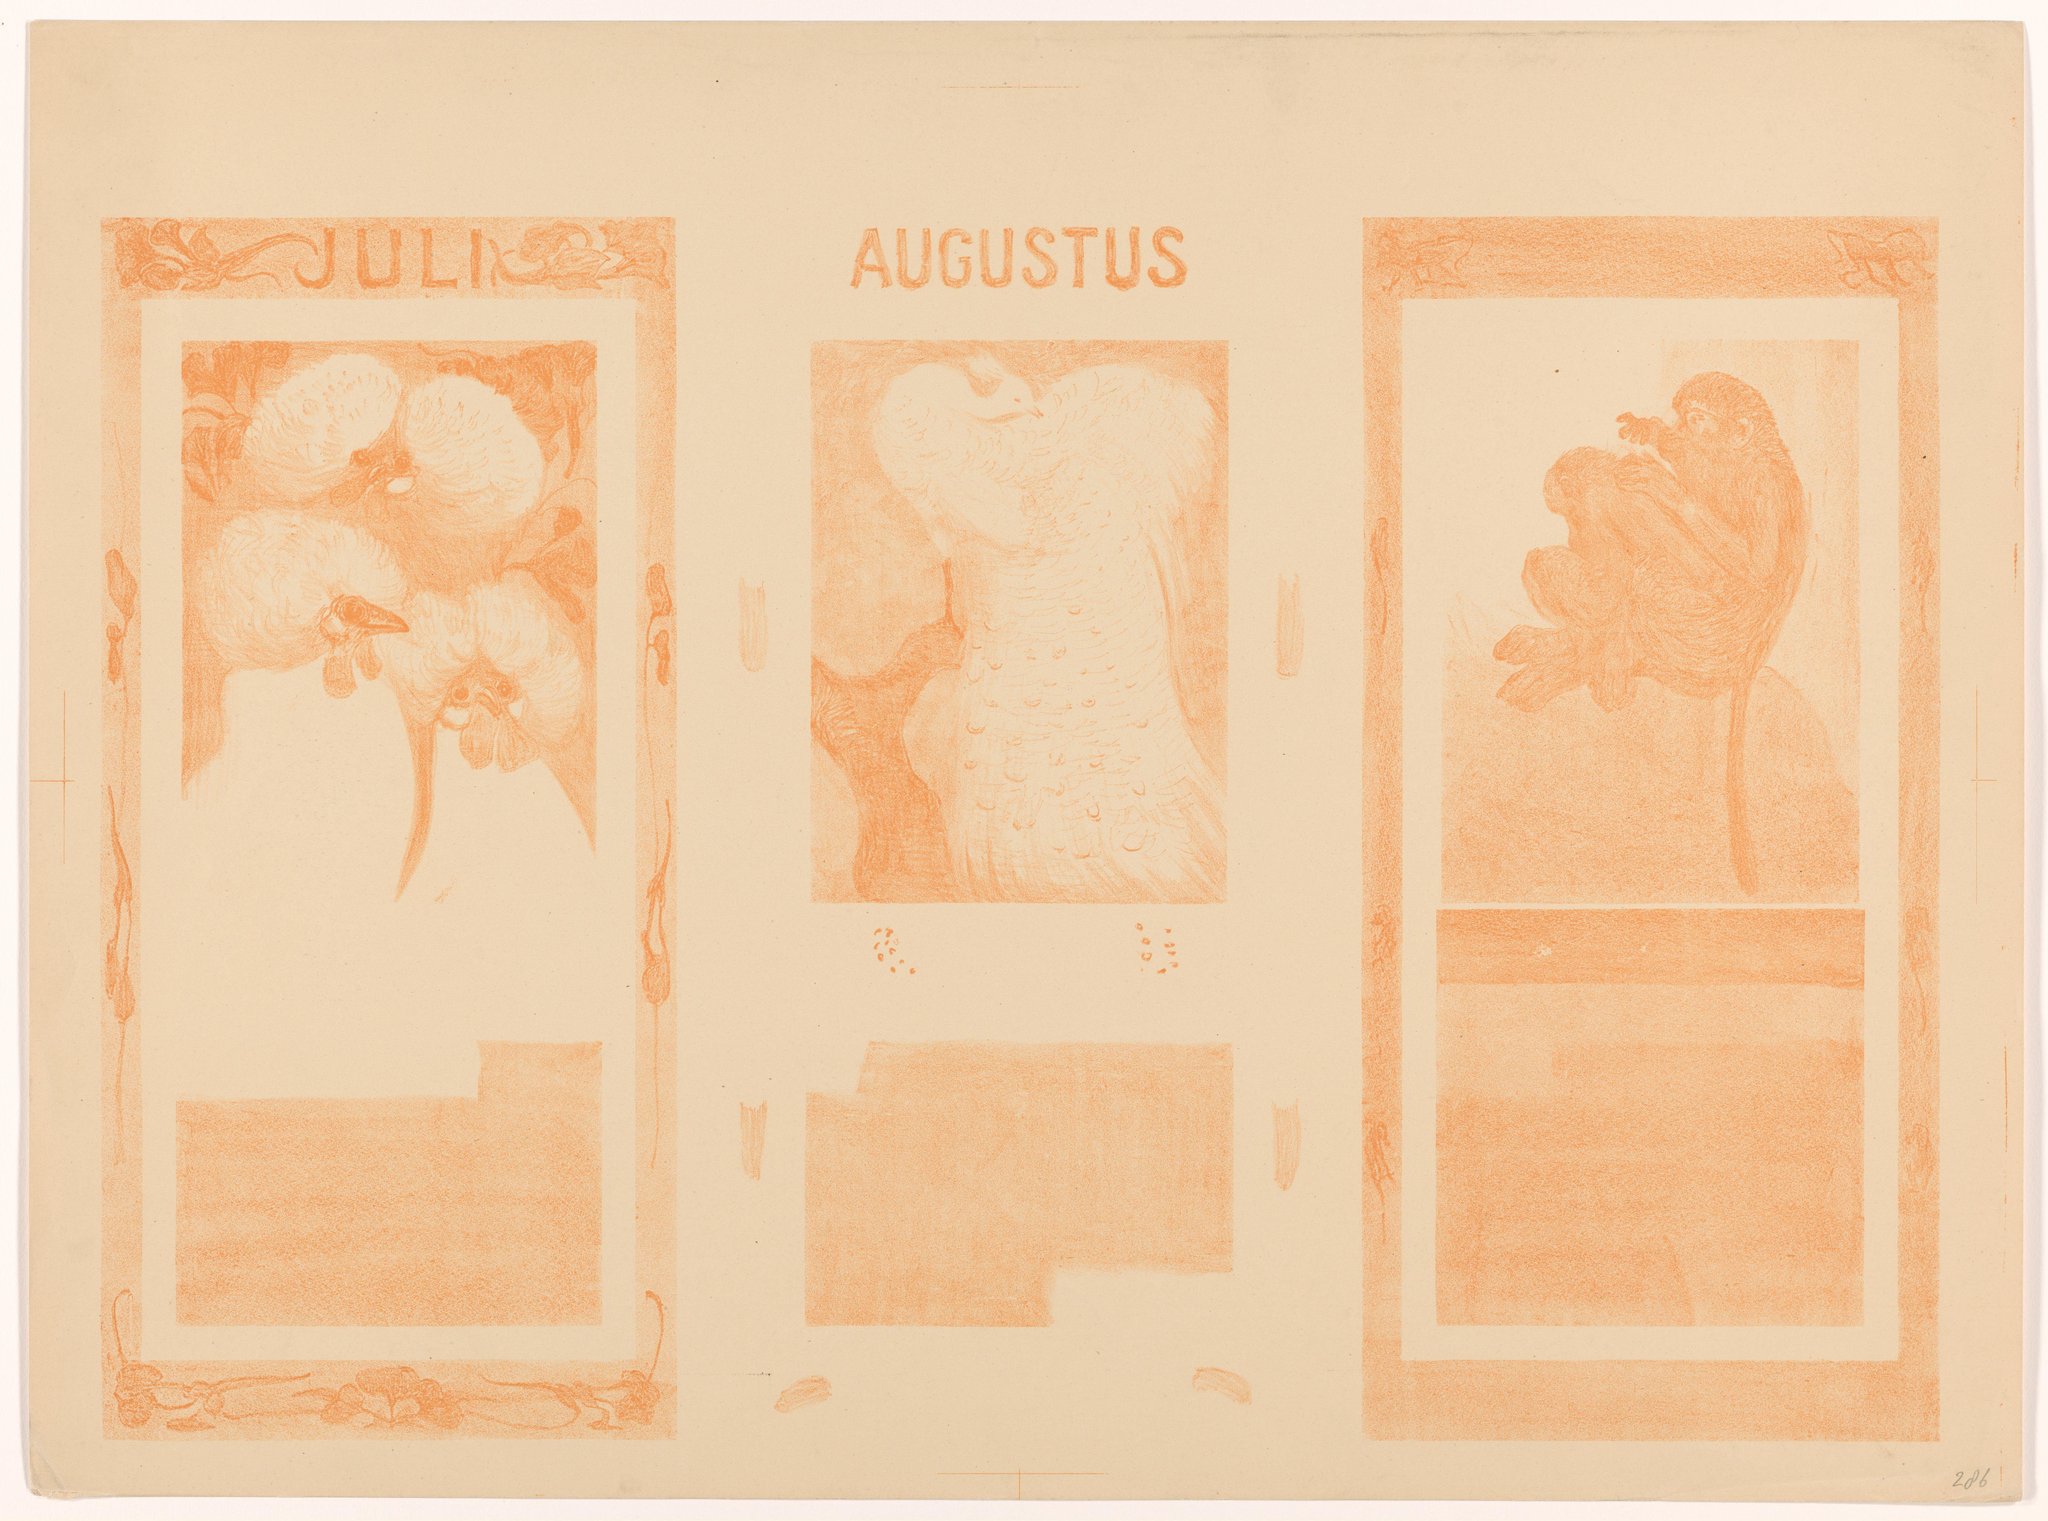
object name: print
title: Kalenders voor juli, augustus en november 1910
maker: theo van hoytema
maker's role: draughtsman, painter, print maker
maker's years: 1863-1917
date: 1910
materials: paper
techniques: lithograph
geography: amsterdam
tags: calendar, almanac, monkeys, apes, ornamental birds: peacock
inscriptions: collector's mark: Lugt 4731, collector's mark: Lugt 2228